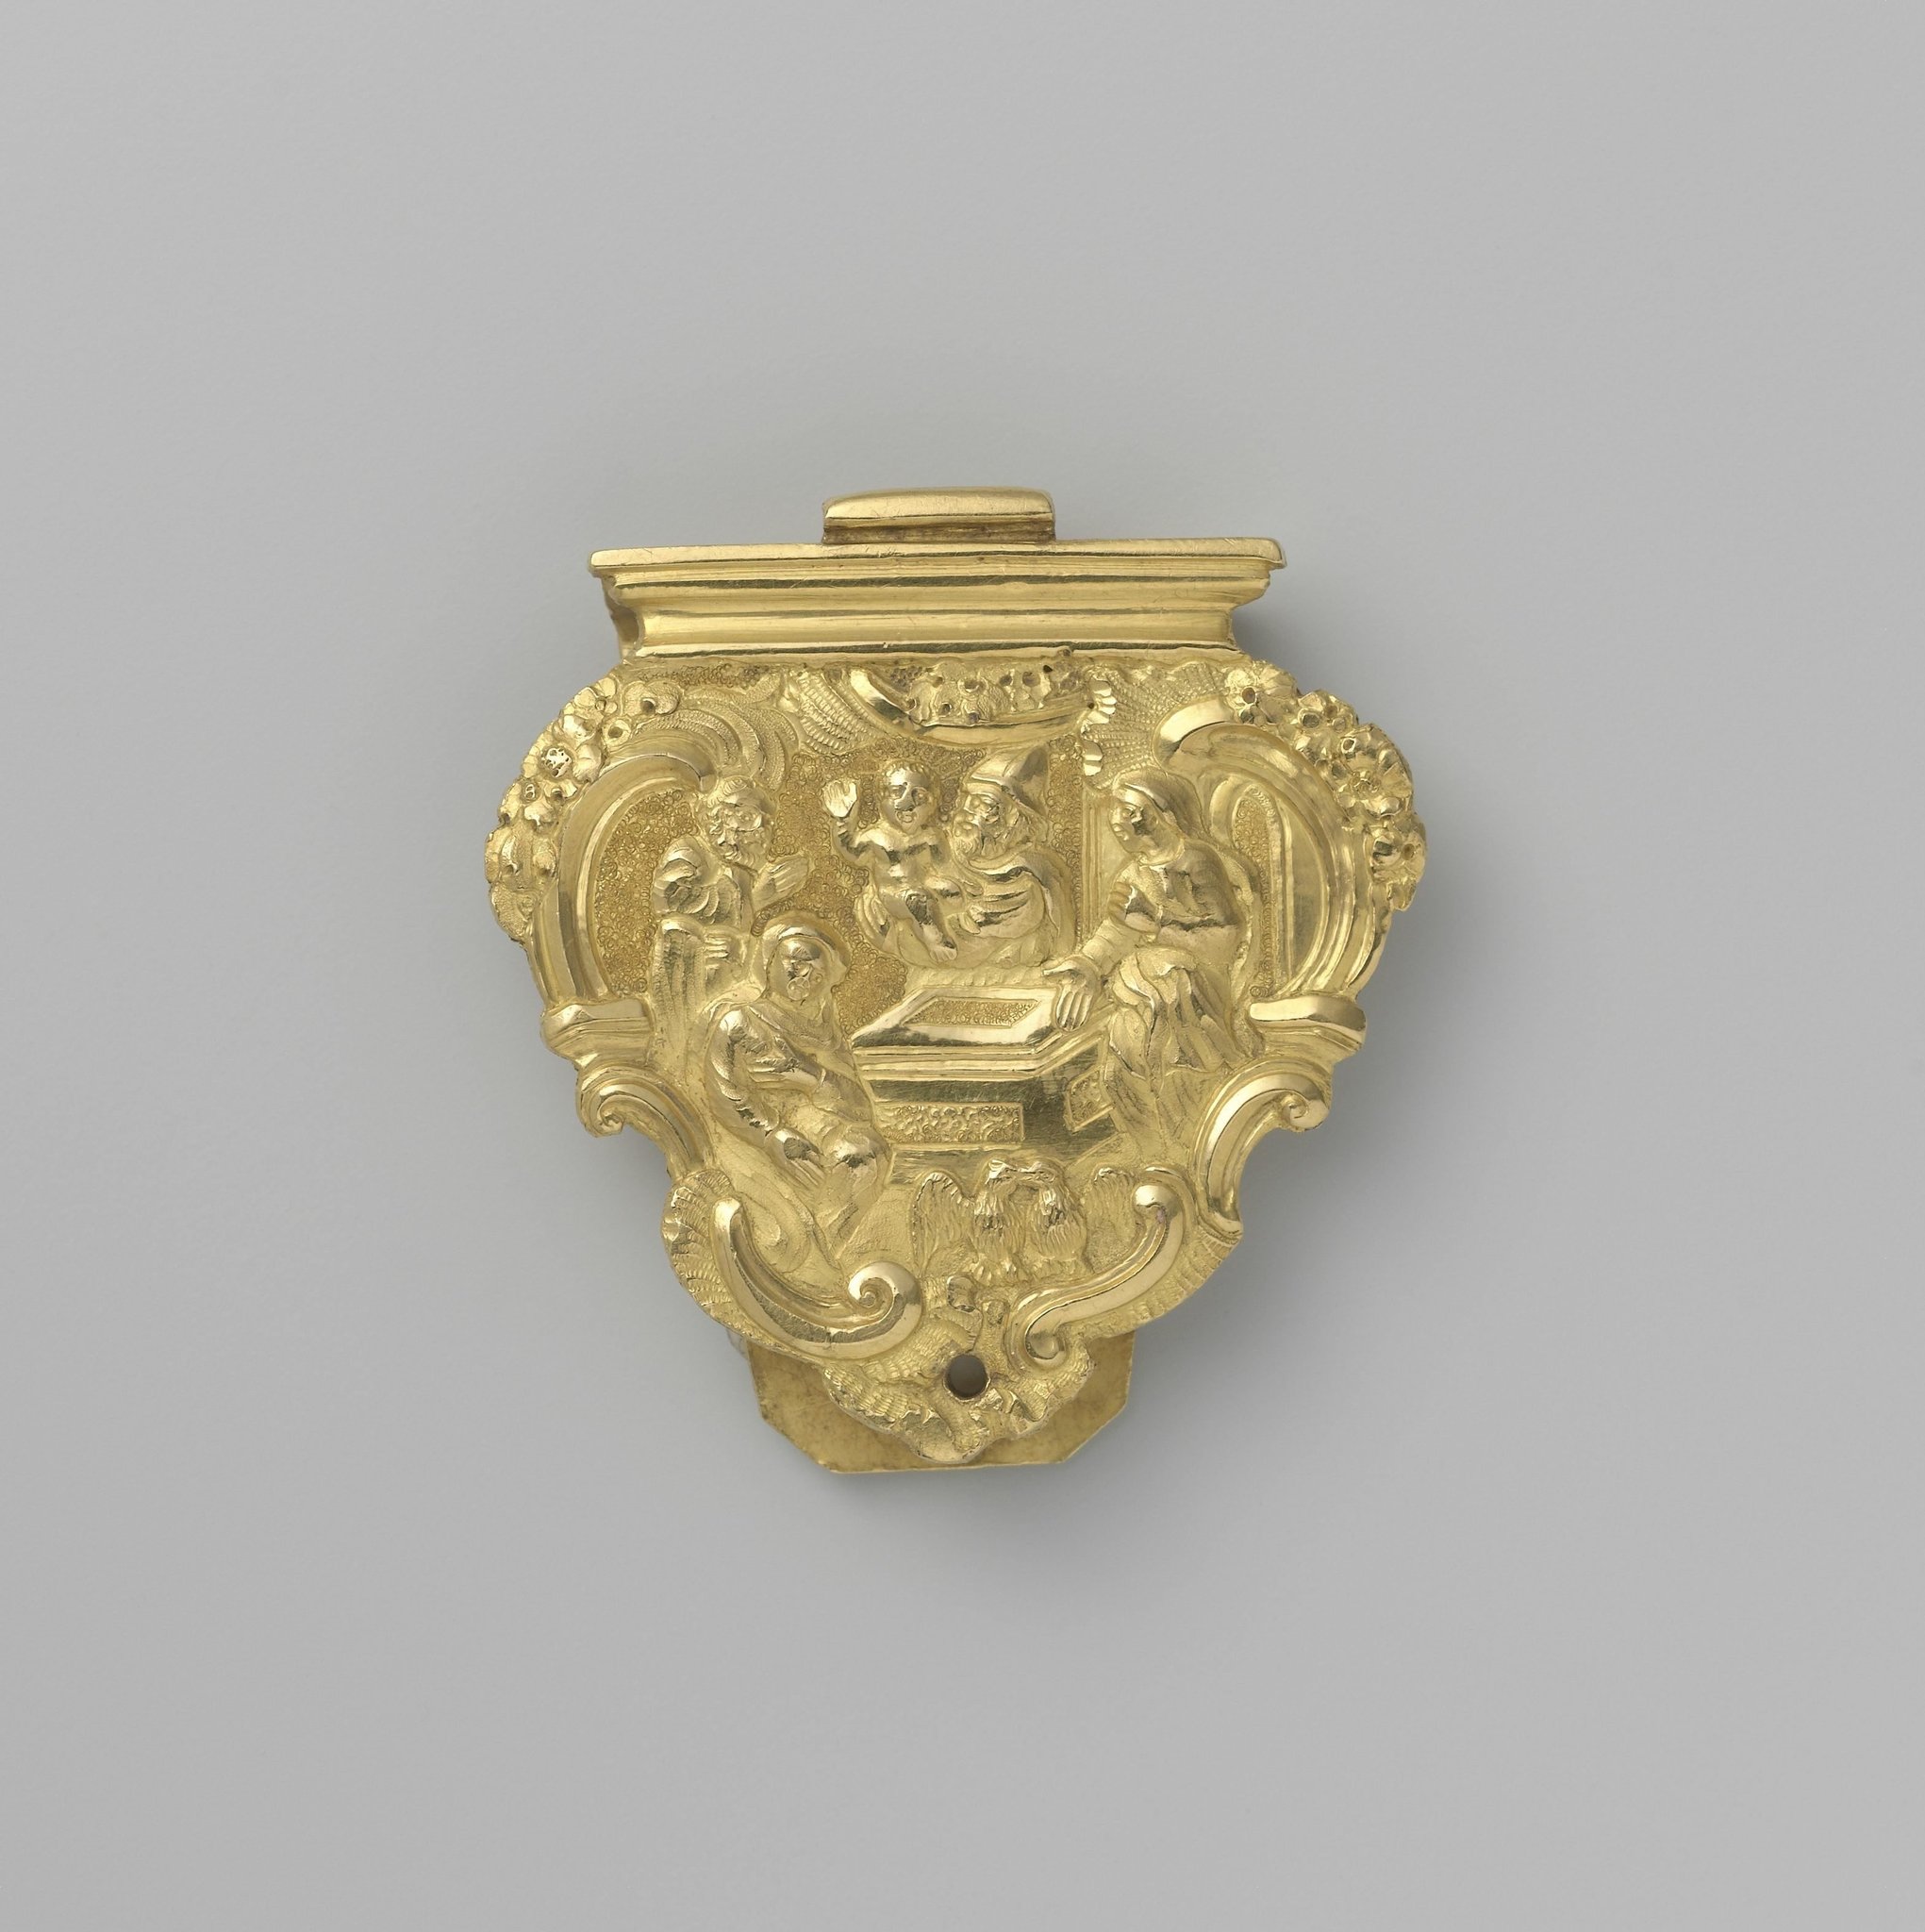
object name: boekslot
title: Klamp van een boekslot met voorstelling van de presentatie van Jezus in de tempel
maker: Anonymous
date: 1773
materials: gold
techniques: casting, metalworking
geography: the hague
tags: presentation of the christ-child in the temple, usually simeon (and anna) present (luke 2:22-39)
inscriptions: alloy mark, town mark, maker's mark, date letter: ‘B’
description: Beugel van een boekslot van goud, gegoten en geciseleerd, met voorstelling in reliëf van de presentatie van Jezus in de tempel. De voorstelling wordt omgeven door rocaille-ornamenten. Bijbelslot.